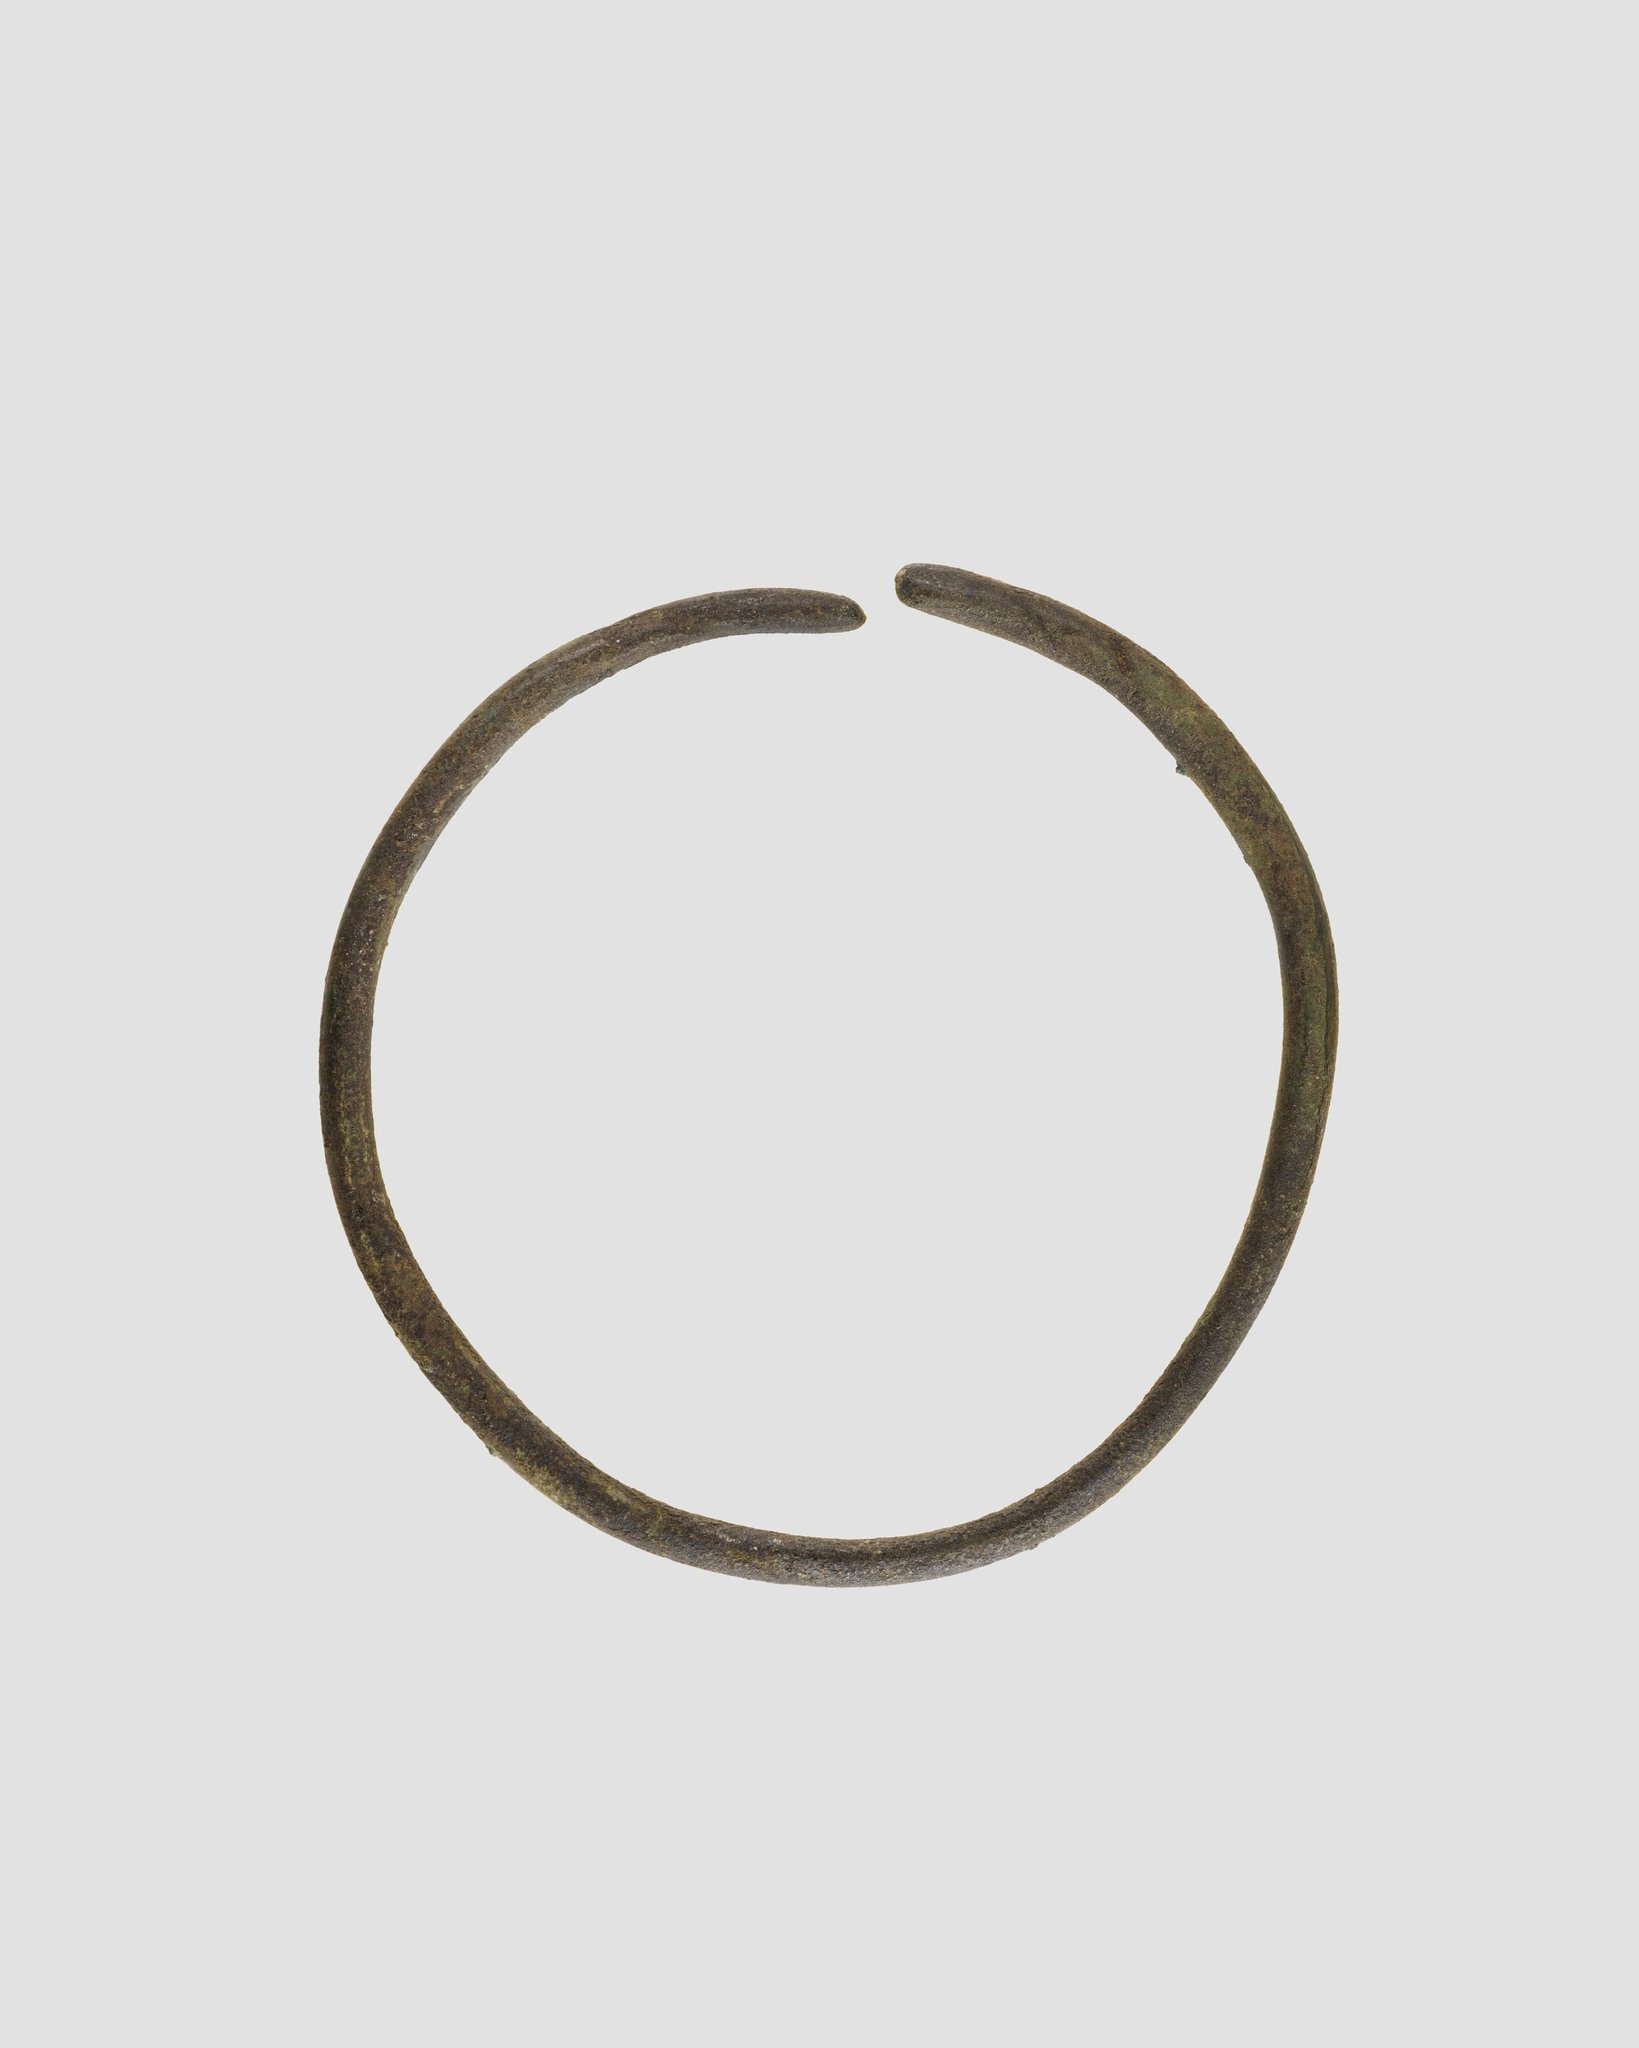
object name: bangle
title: Bronze bangle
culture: alanic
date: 601-900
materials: metal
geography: caucasus